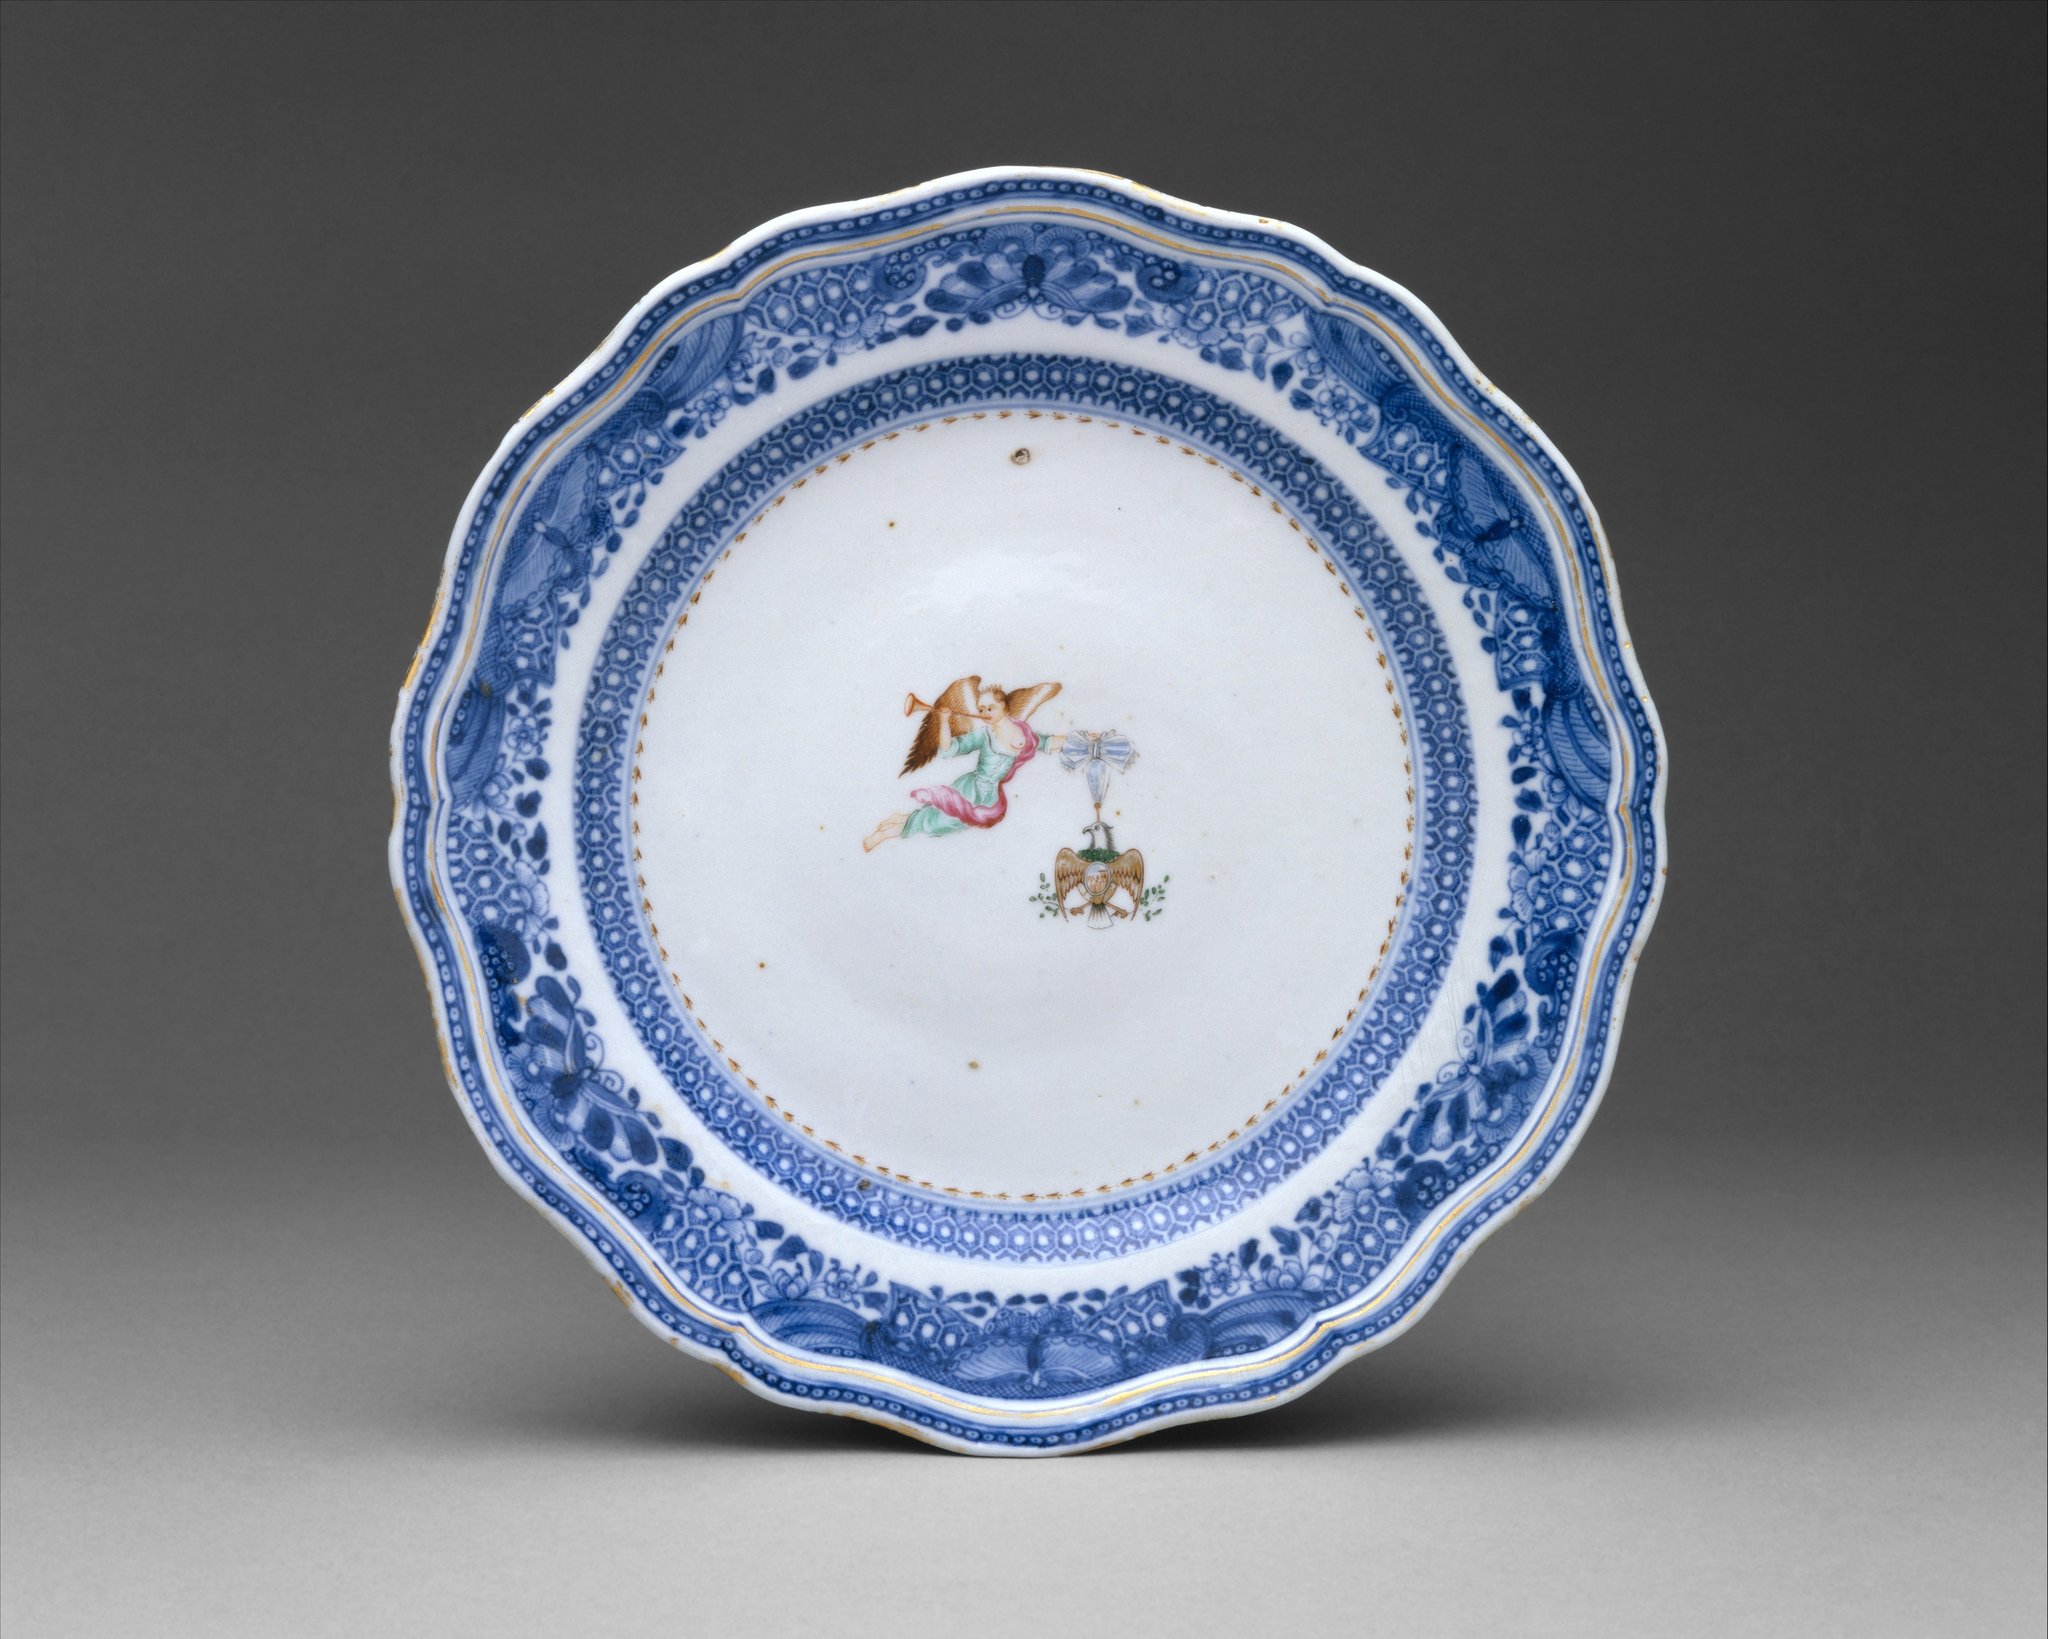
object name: plate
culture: chinese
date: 1785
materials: hard paste porcelain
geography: china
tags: eagles,angels